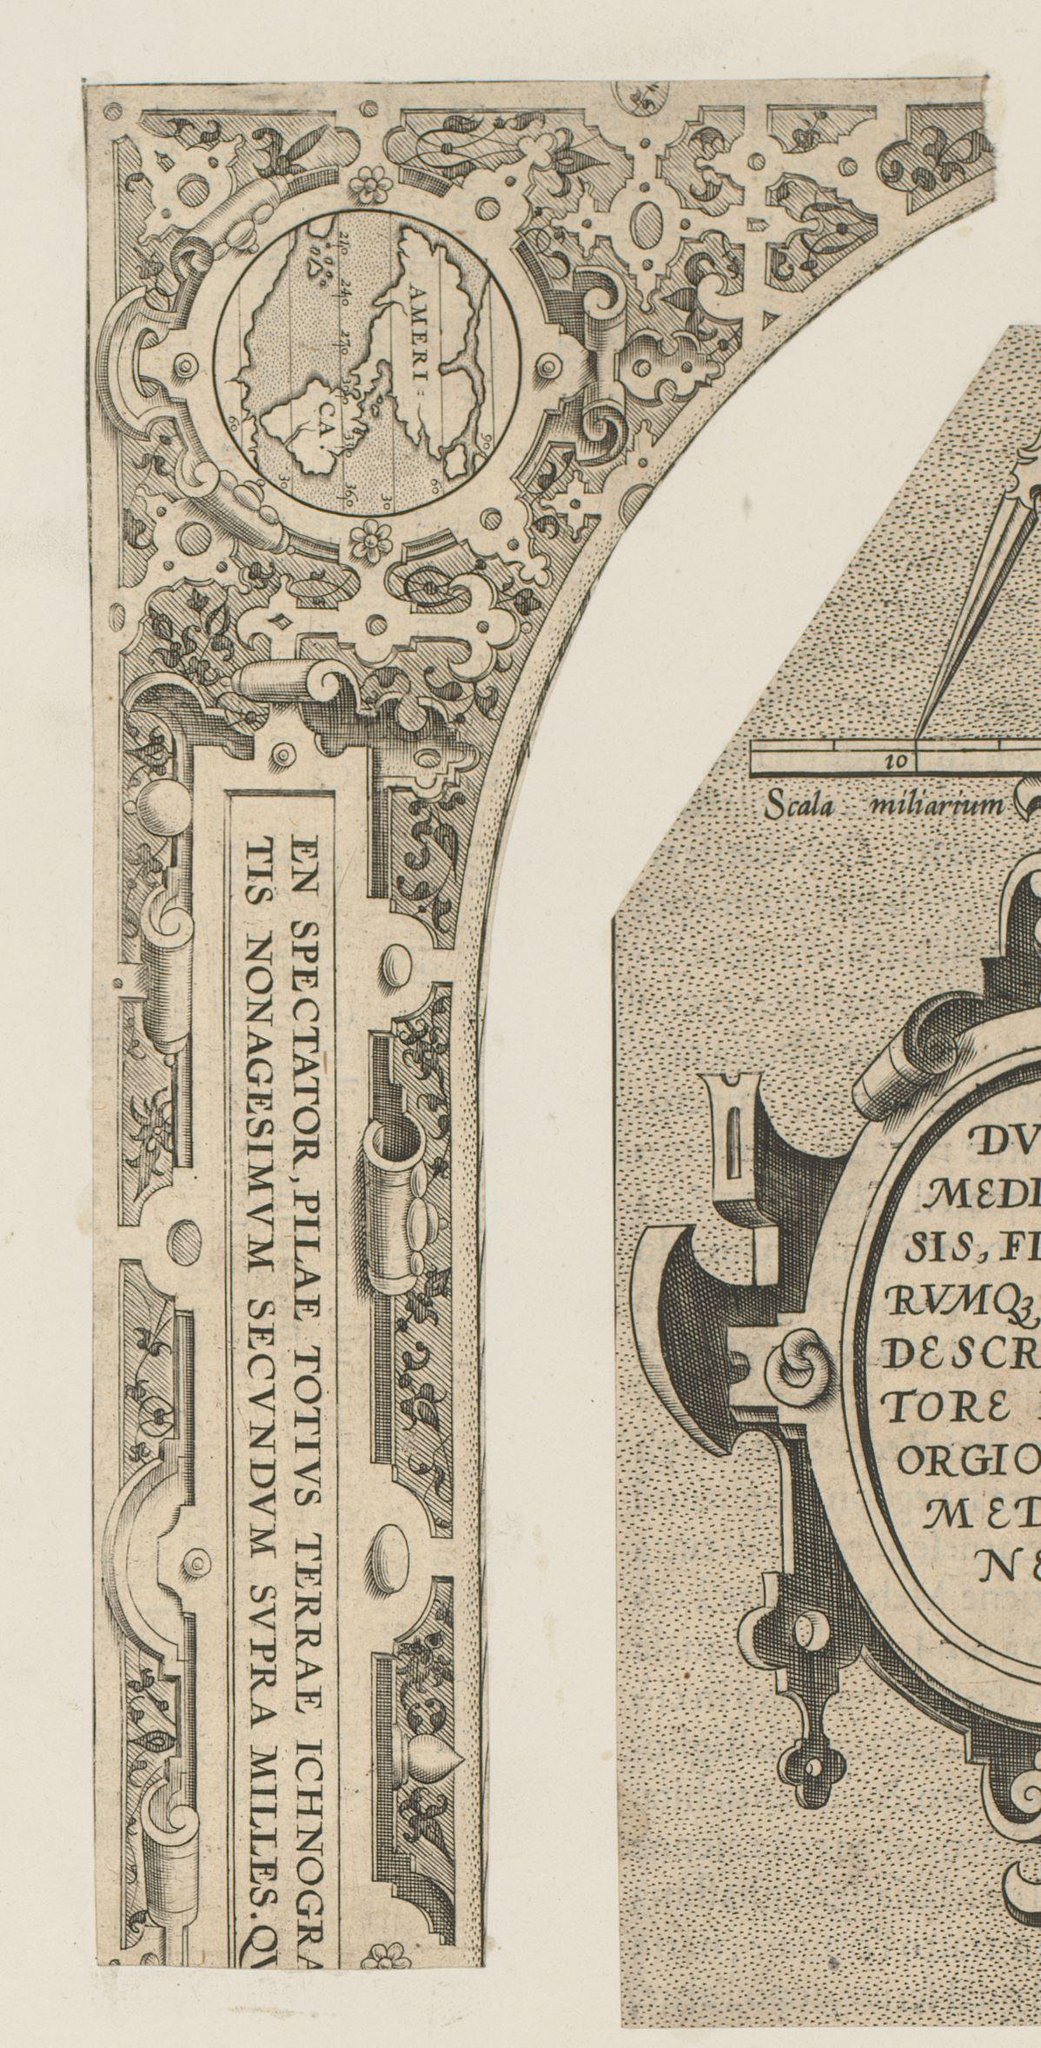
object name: ornament print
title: Theatrum Orbis Terrarum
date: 1590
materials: paper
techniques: engraving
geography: antwerp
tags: ornaments ~ art, ornament ~ cartouche, (map of) america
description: Hoekornament met een ronde kaart van Noord- en Zuid-Amerika in een omlijsting van rol- en beslagwerk. Midden onder een langwerpig cartouche met de tekst: En Spectator ... Het ornament is een fragment van een kaart van de Oude Wereld. De prent maakt deel uit van een album.